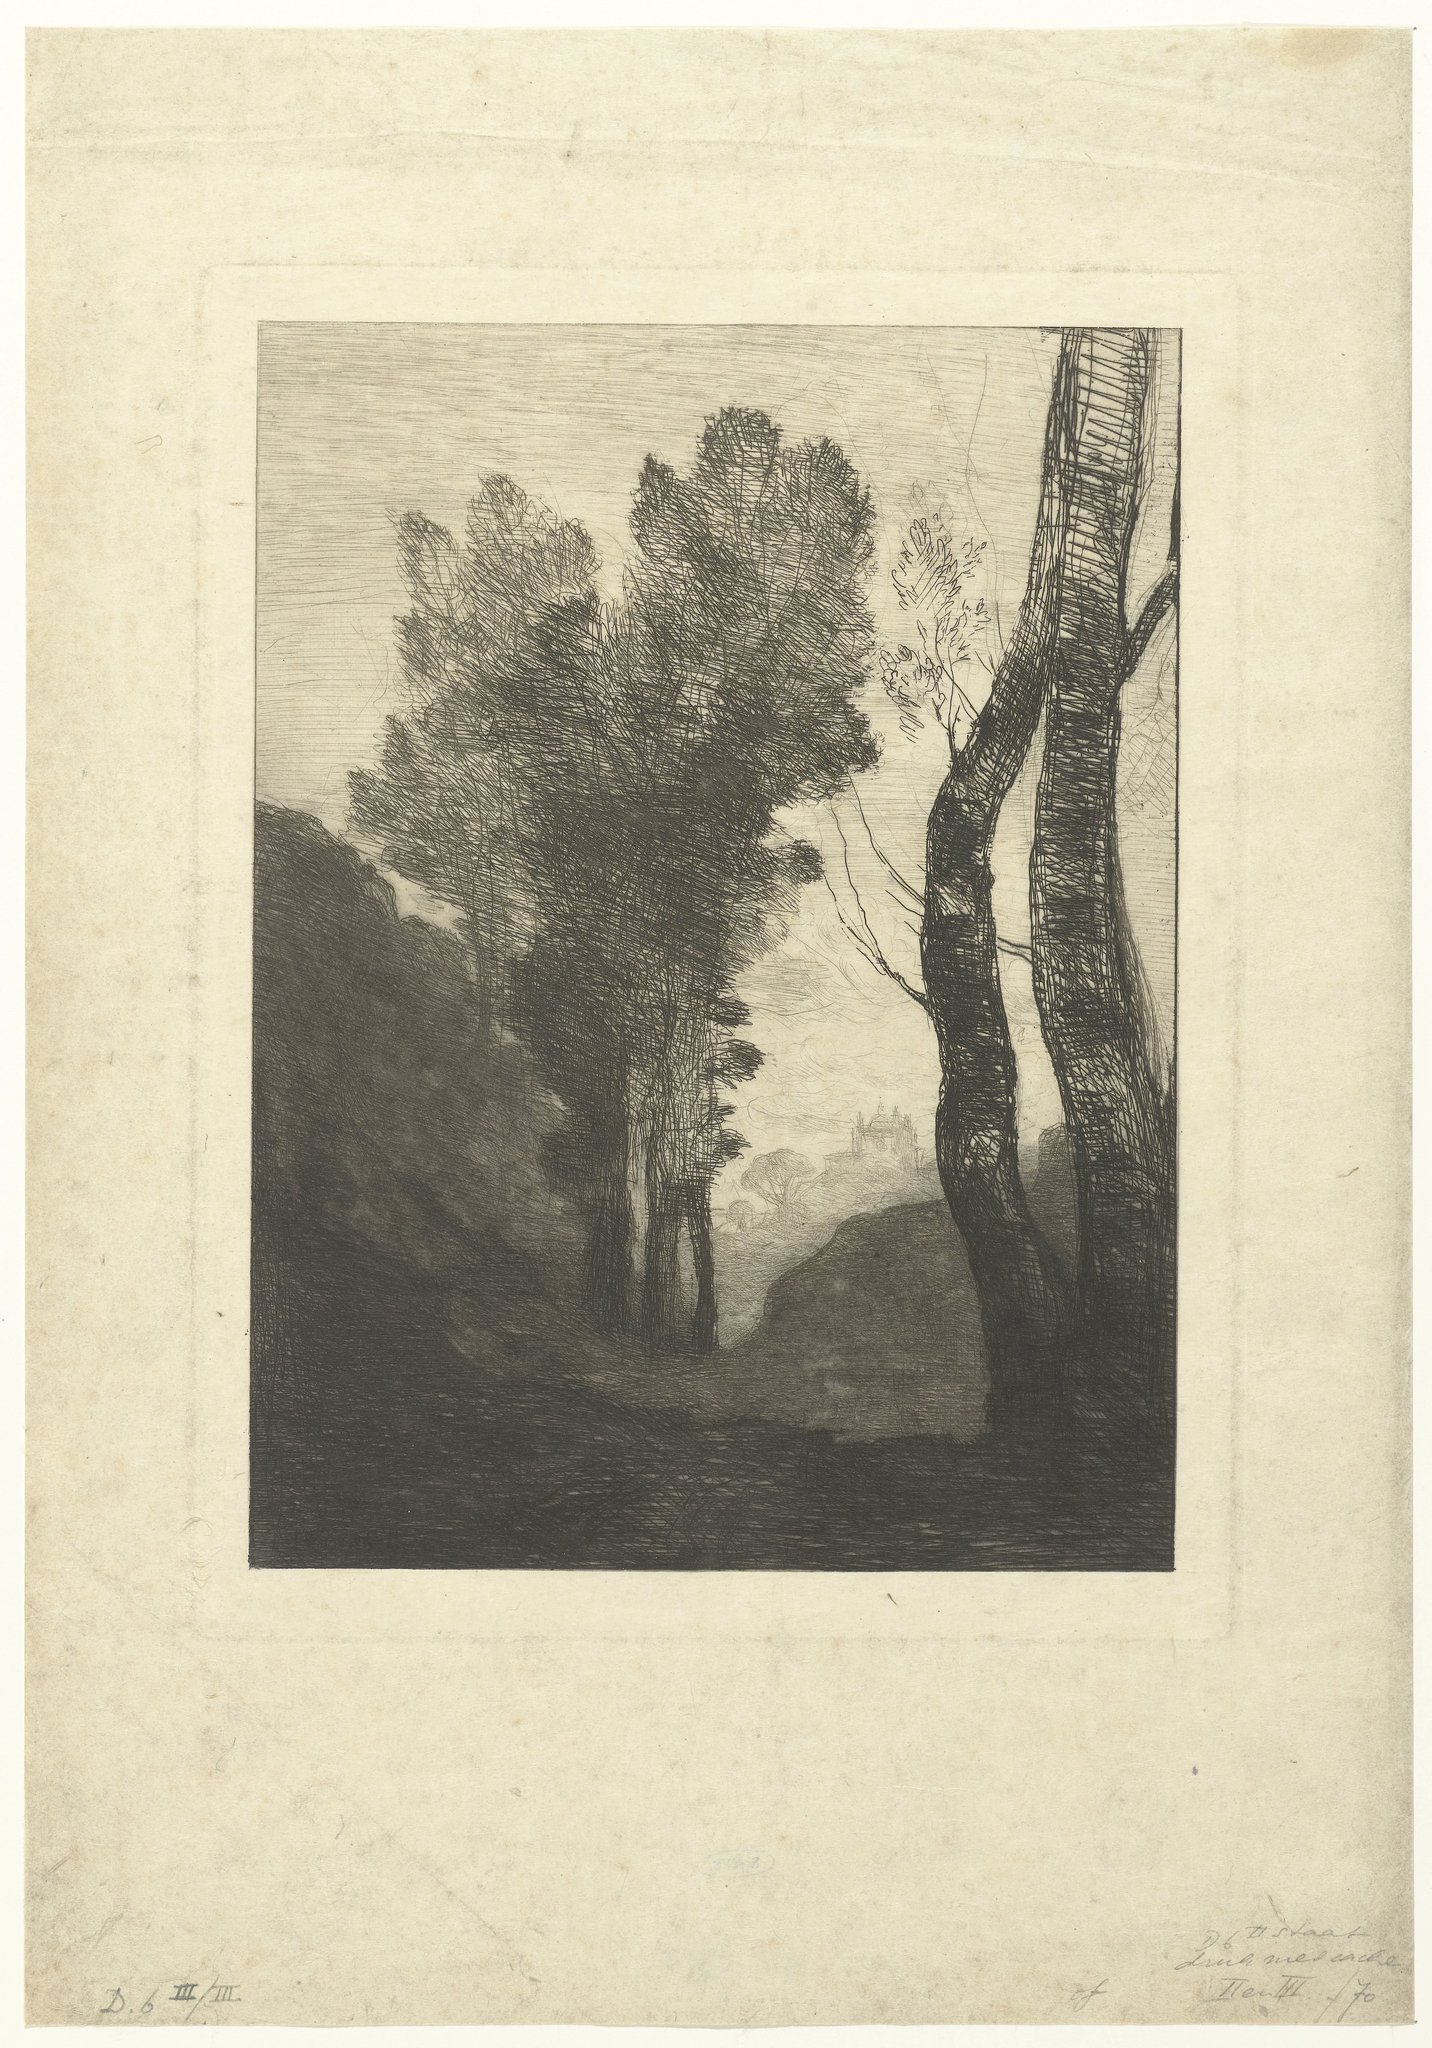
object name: print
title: Landschap met bomen in omgeving van Rome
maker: camille corot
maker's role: draughtsman, painter, print maker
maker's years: 1796-1875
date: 1866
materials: paper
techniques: etching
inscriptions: collector's mark: Lugt 2228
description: De tweede staat van dit landschap werd gepubliceerd in het tijdschrift van de Société des Aquafortistes op 1 maart 1866 (nummer 211).